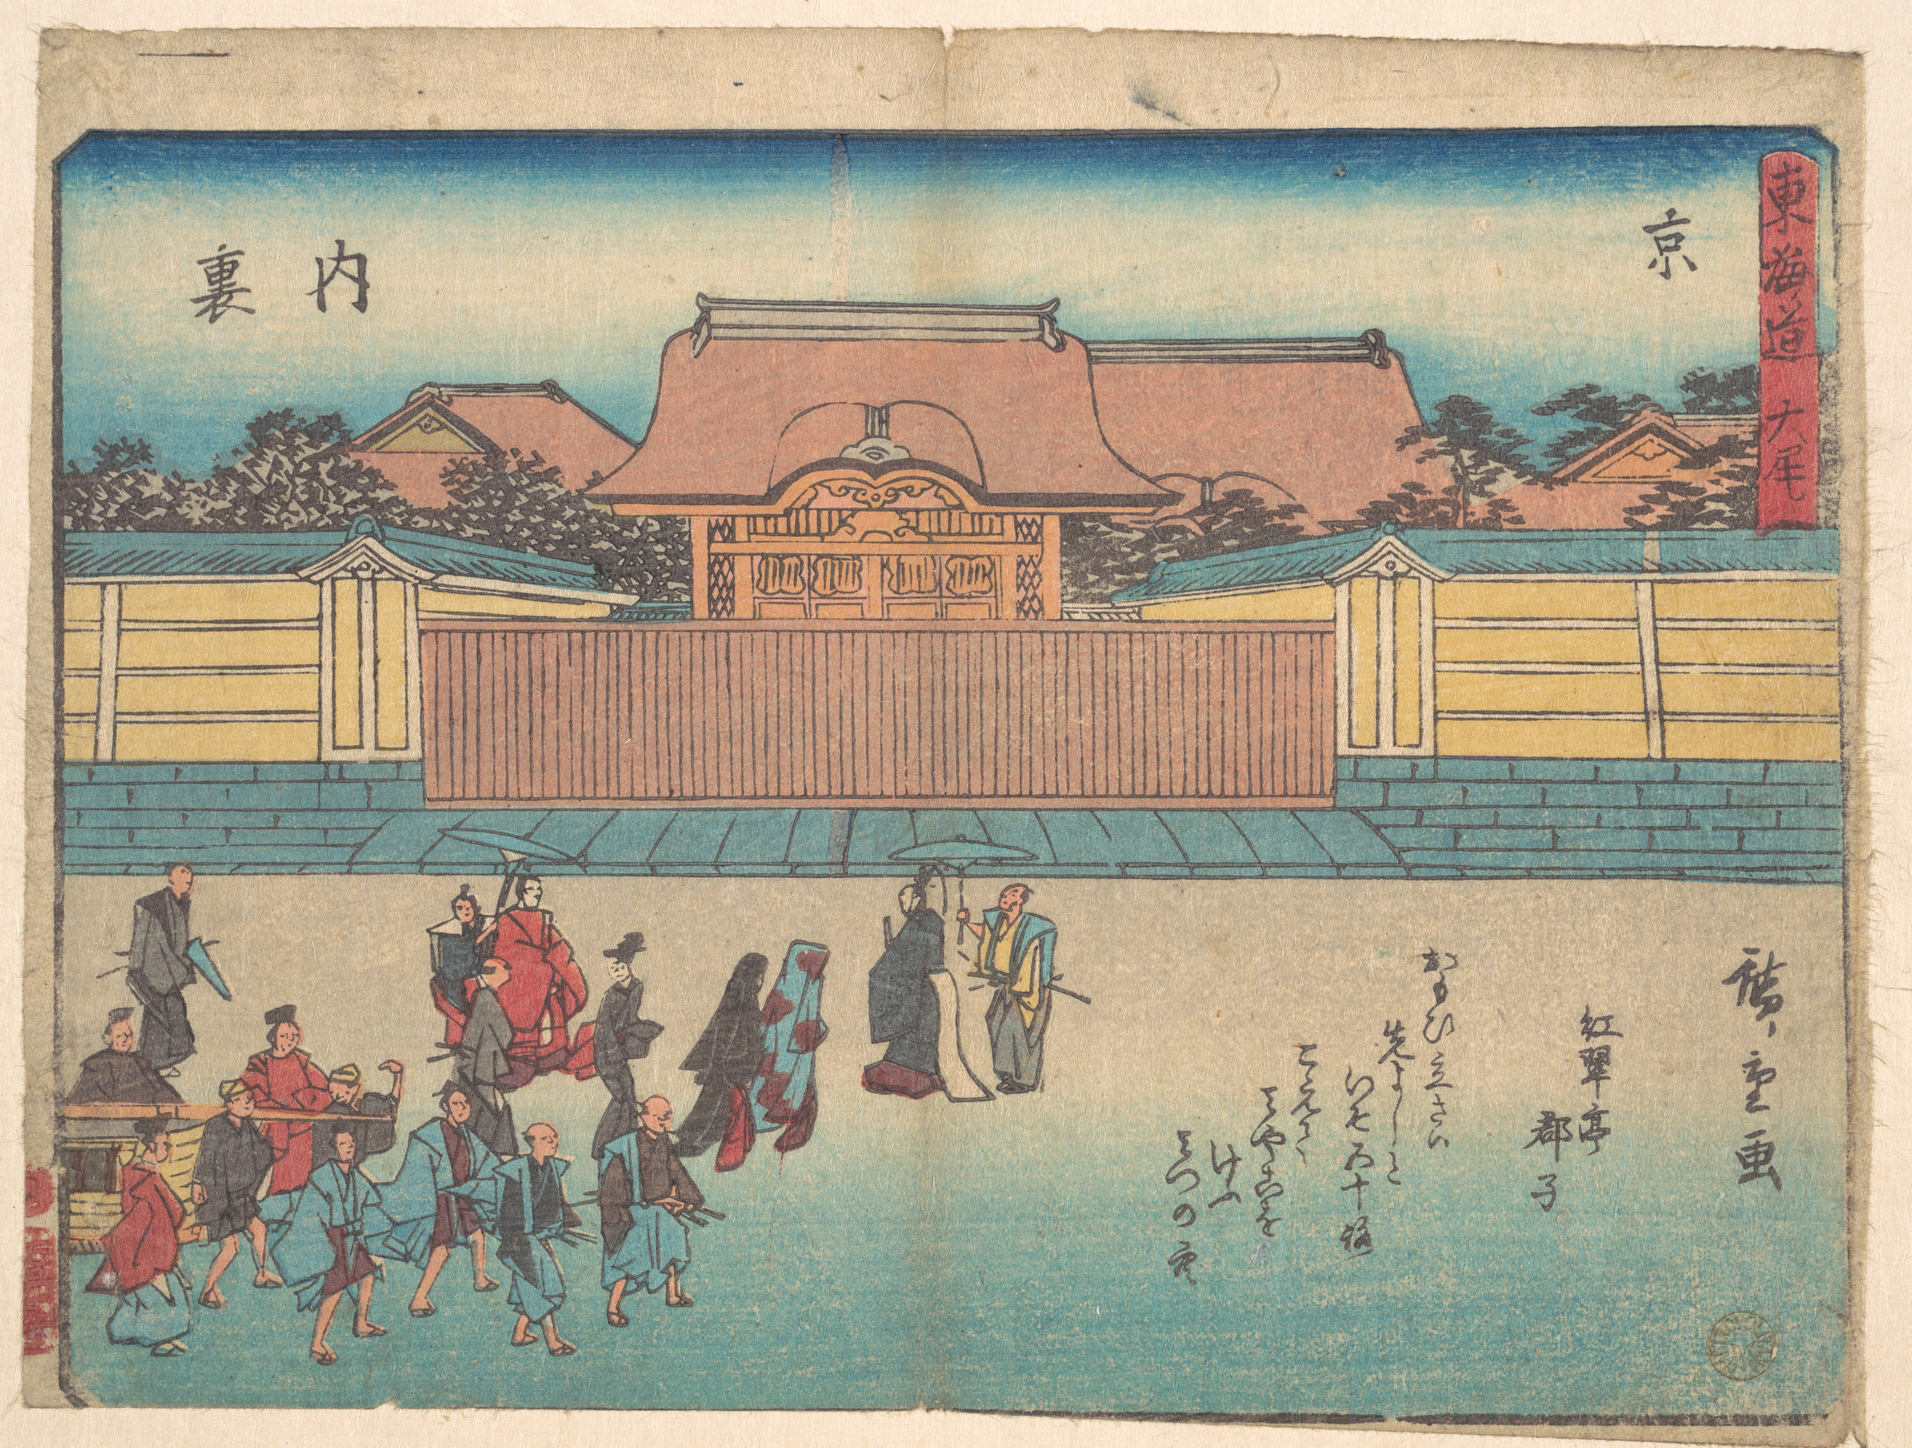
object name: print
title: Kyoto: Dairi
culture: japanese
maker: utagawa hiroshige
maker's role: artist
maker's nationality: japanese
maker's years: 1797-1858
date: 1838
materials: ink, paper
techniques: woodblock print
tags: human figures,houses